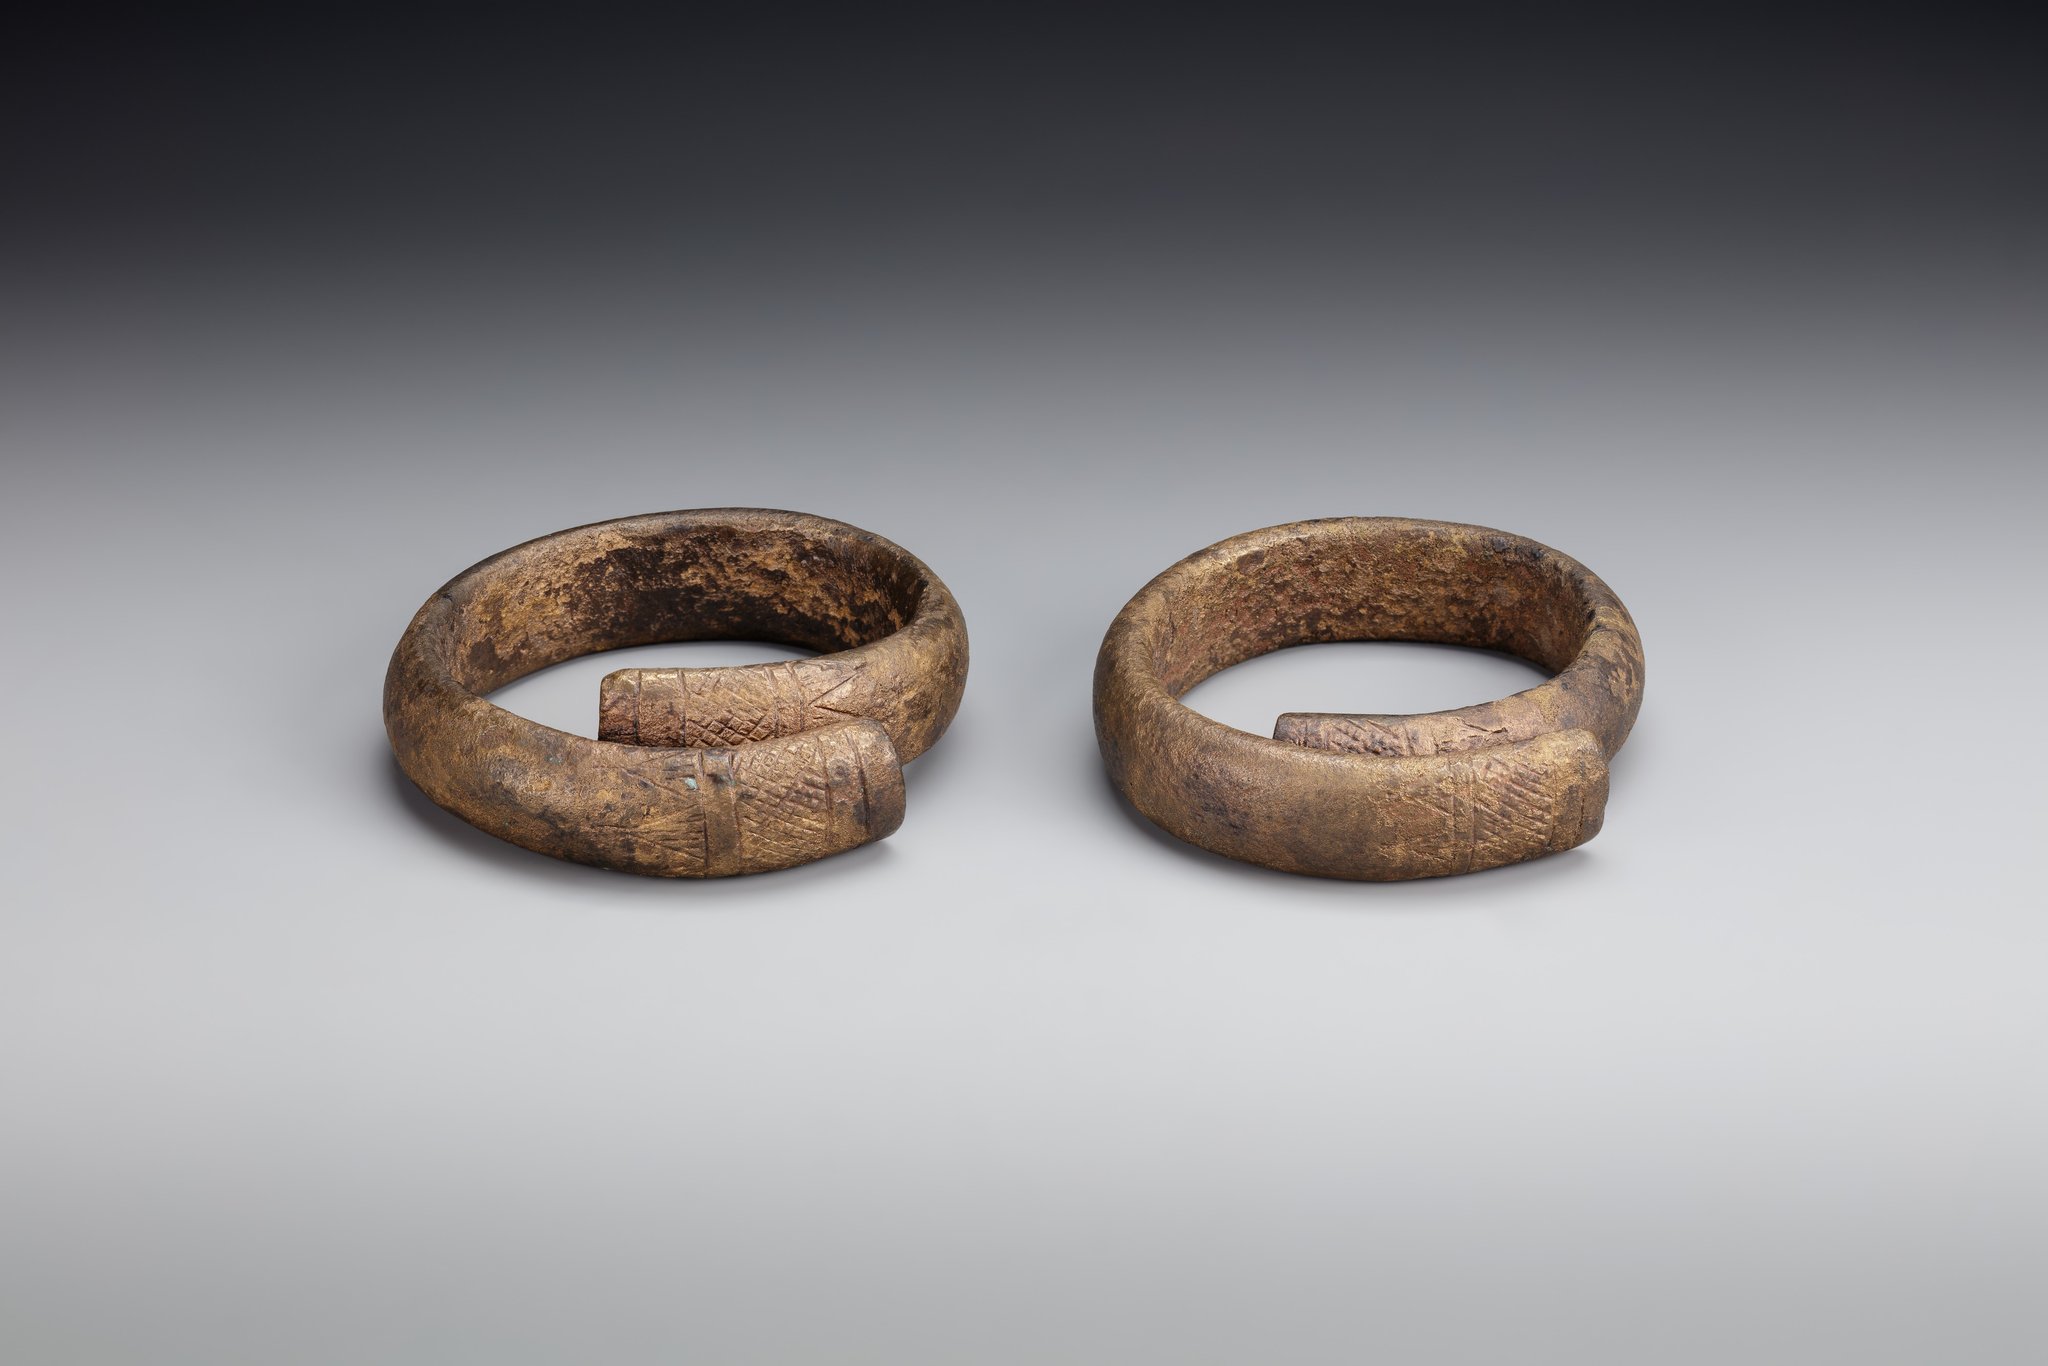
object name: anklet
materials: copper alloy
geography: nubia